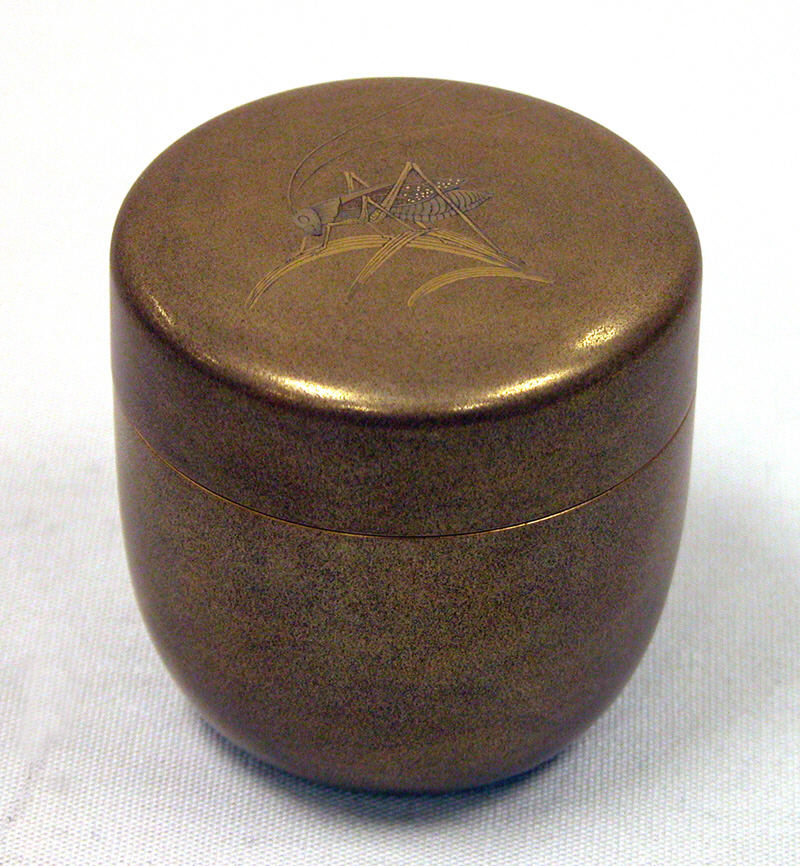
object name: box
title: Circular Box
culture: japanese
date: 1801-1900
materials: gold, lacquer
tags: insects